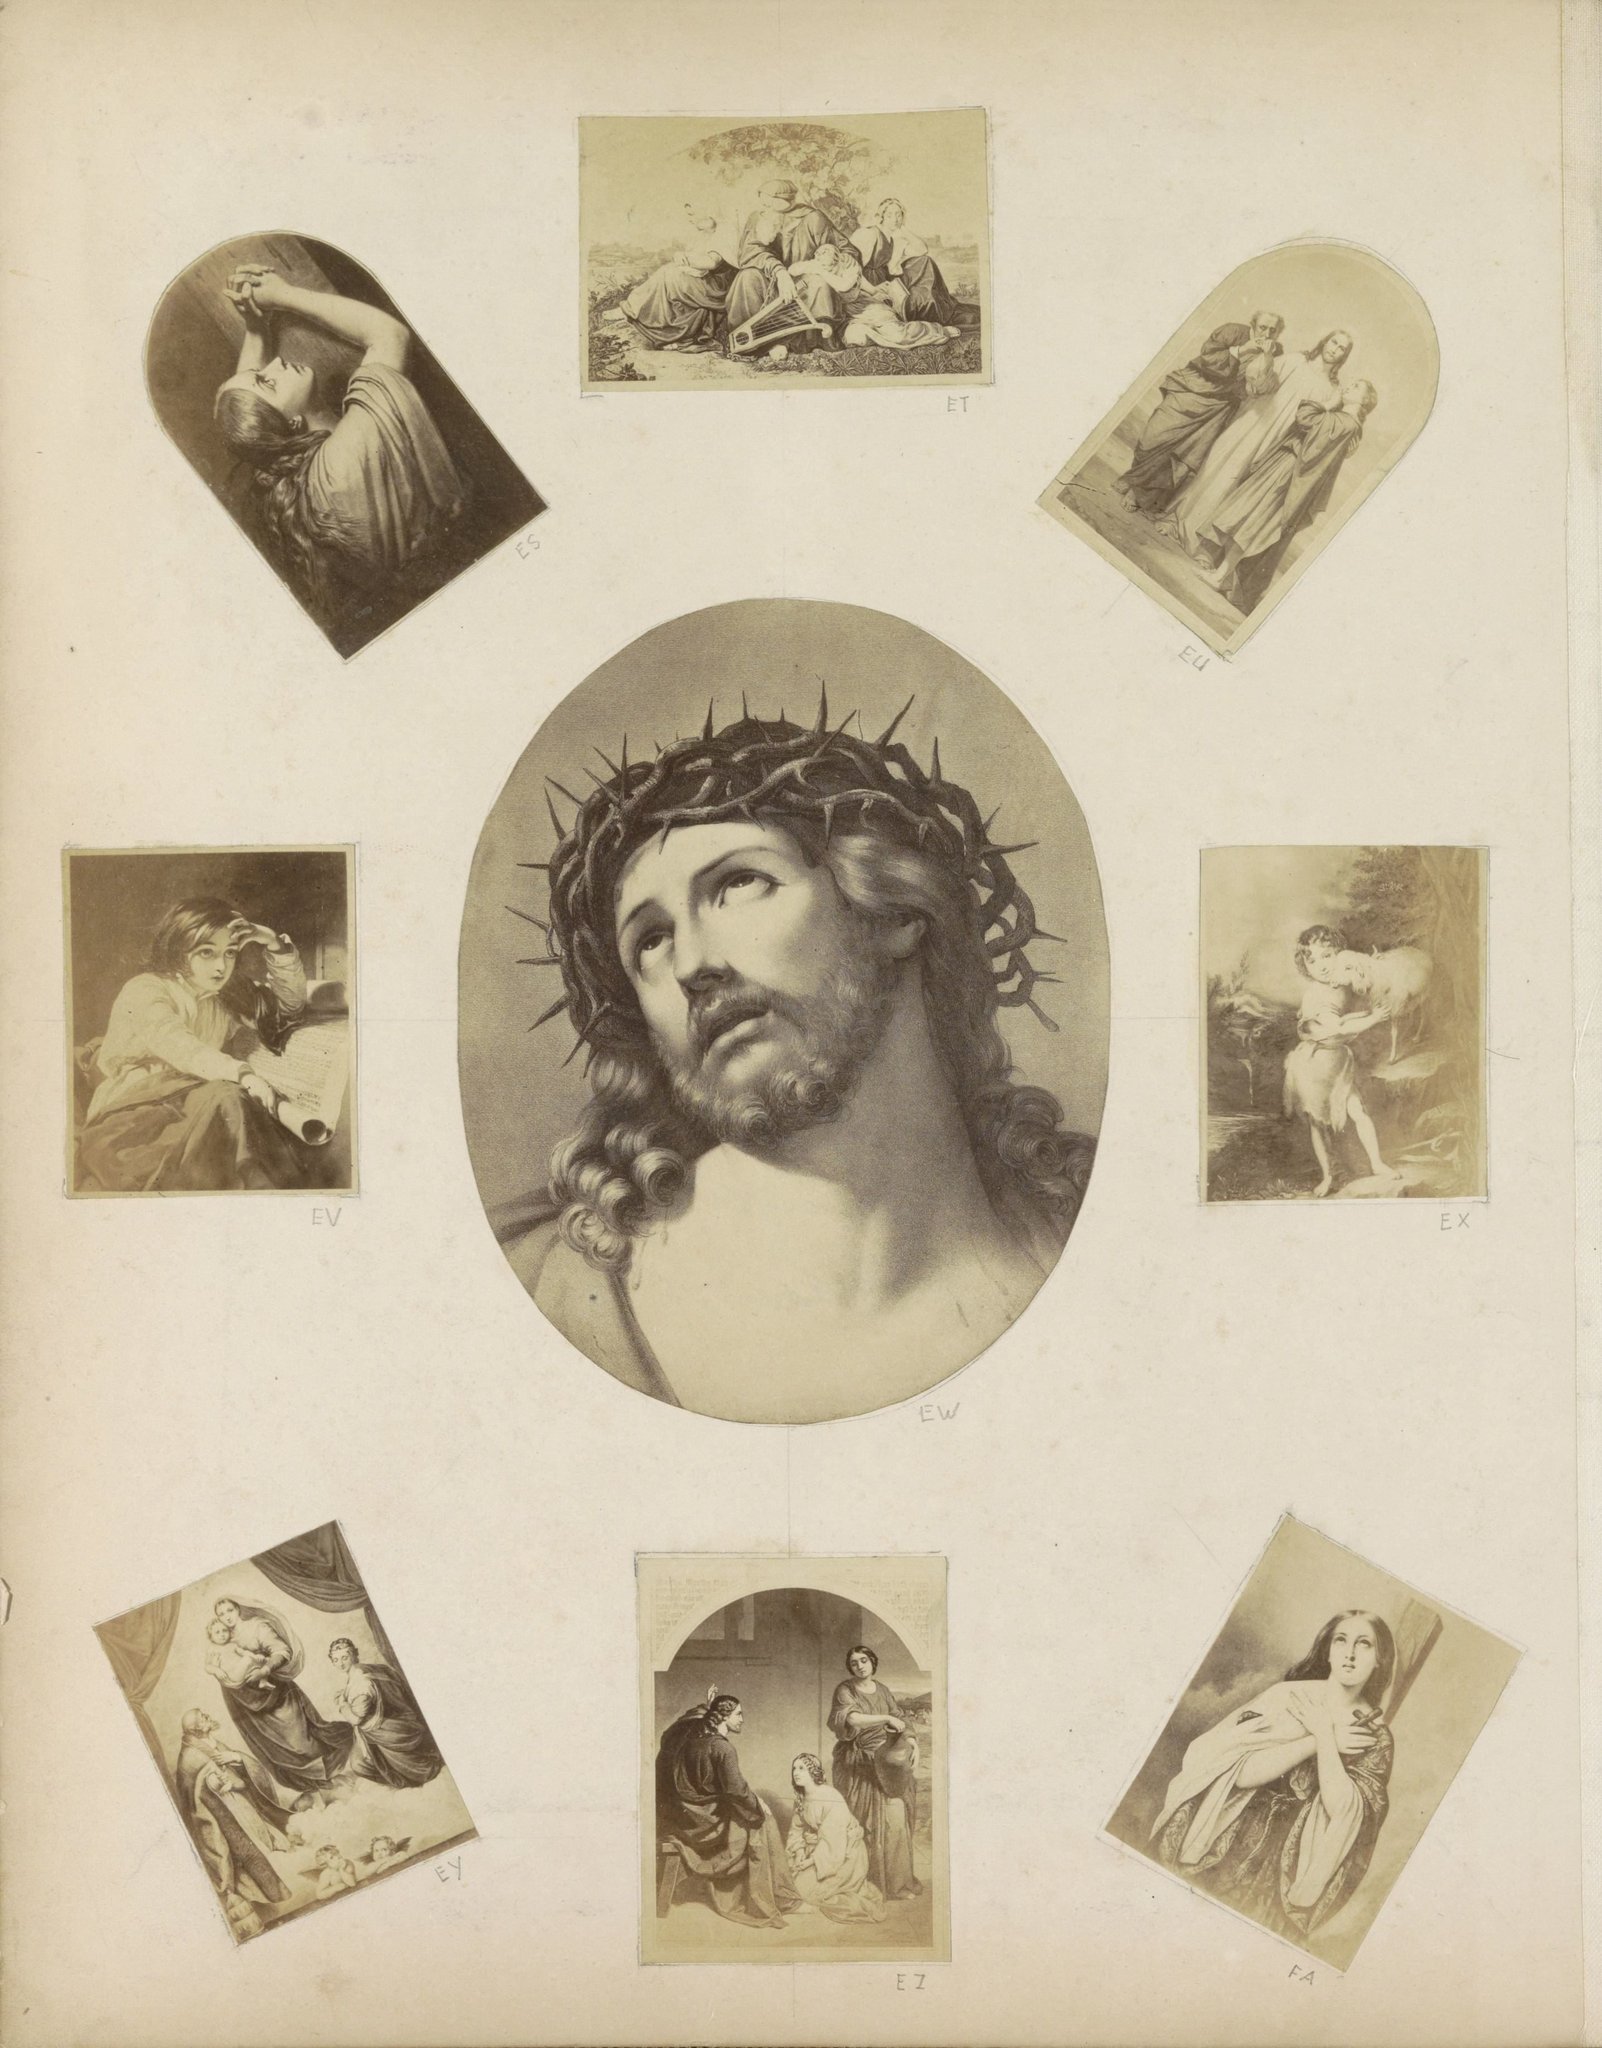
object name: photograph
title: Fotoreproductie van (vermoedelijk) een prent van Johannes de Doper als kind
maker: Anonymous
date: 1850-1870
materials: paper, photographic support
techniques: albumen print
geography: england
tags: john the baptist; possible attributes: book, reed cross, baptismal cup, honeycomb, lamb, staff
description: Onderdeel van Album met foto's van bezienswaardigheden en landschappen in Engeland en van kunst.